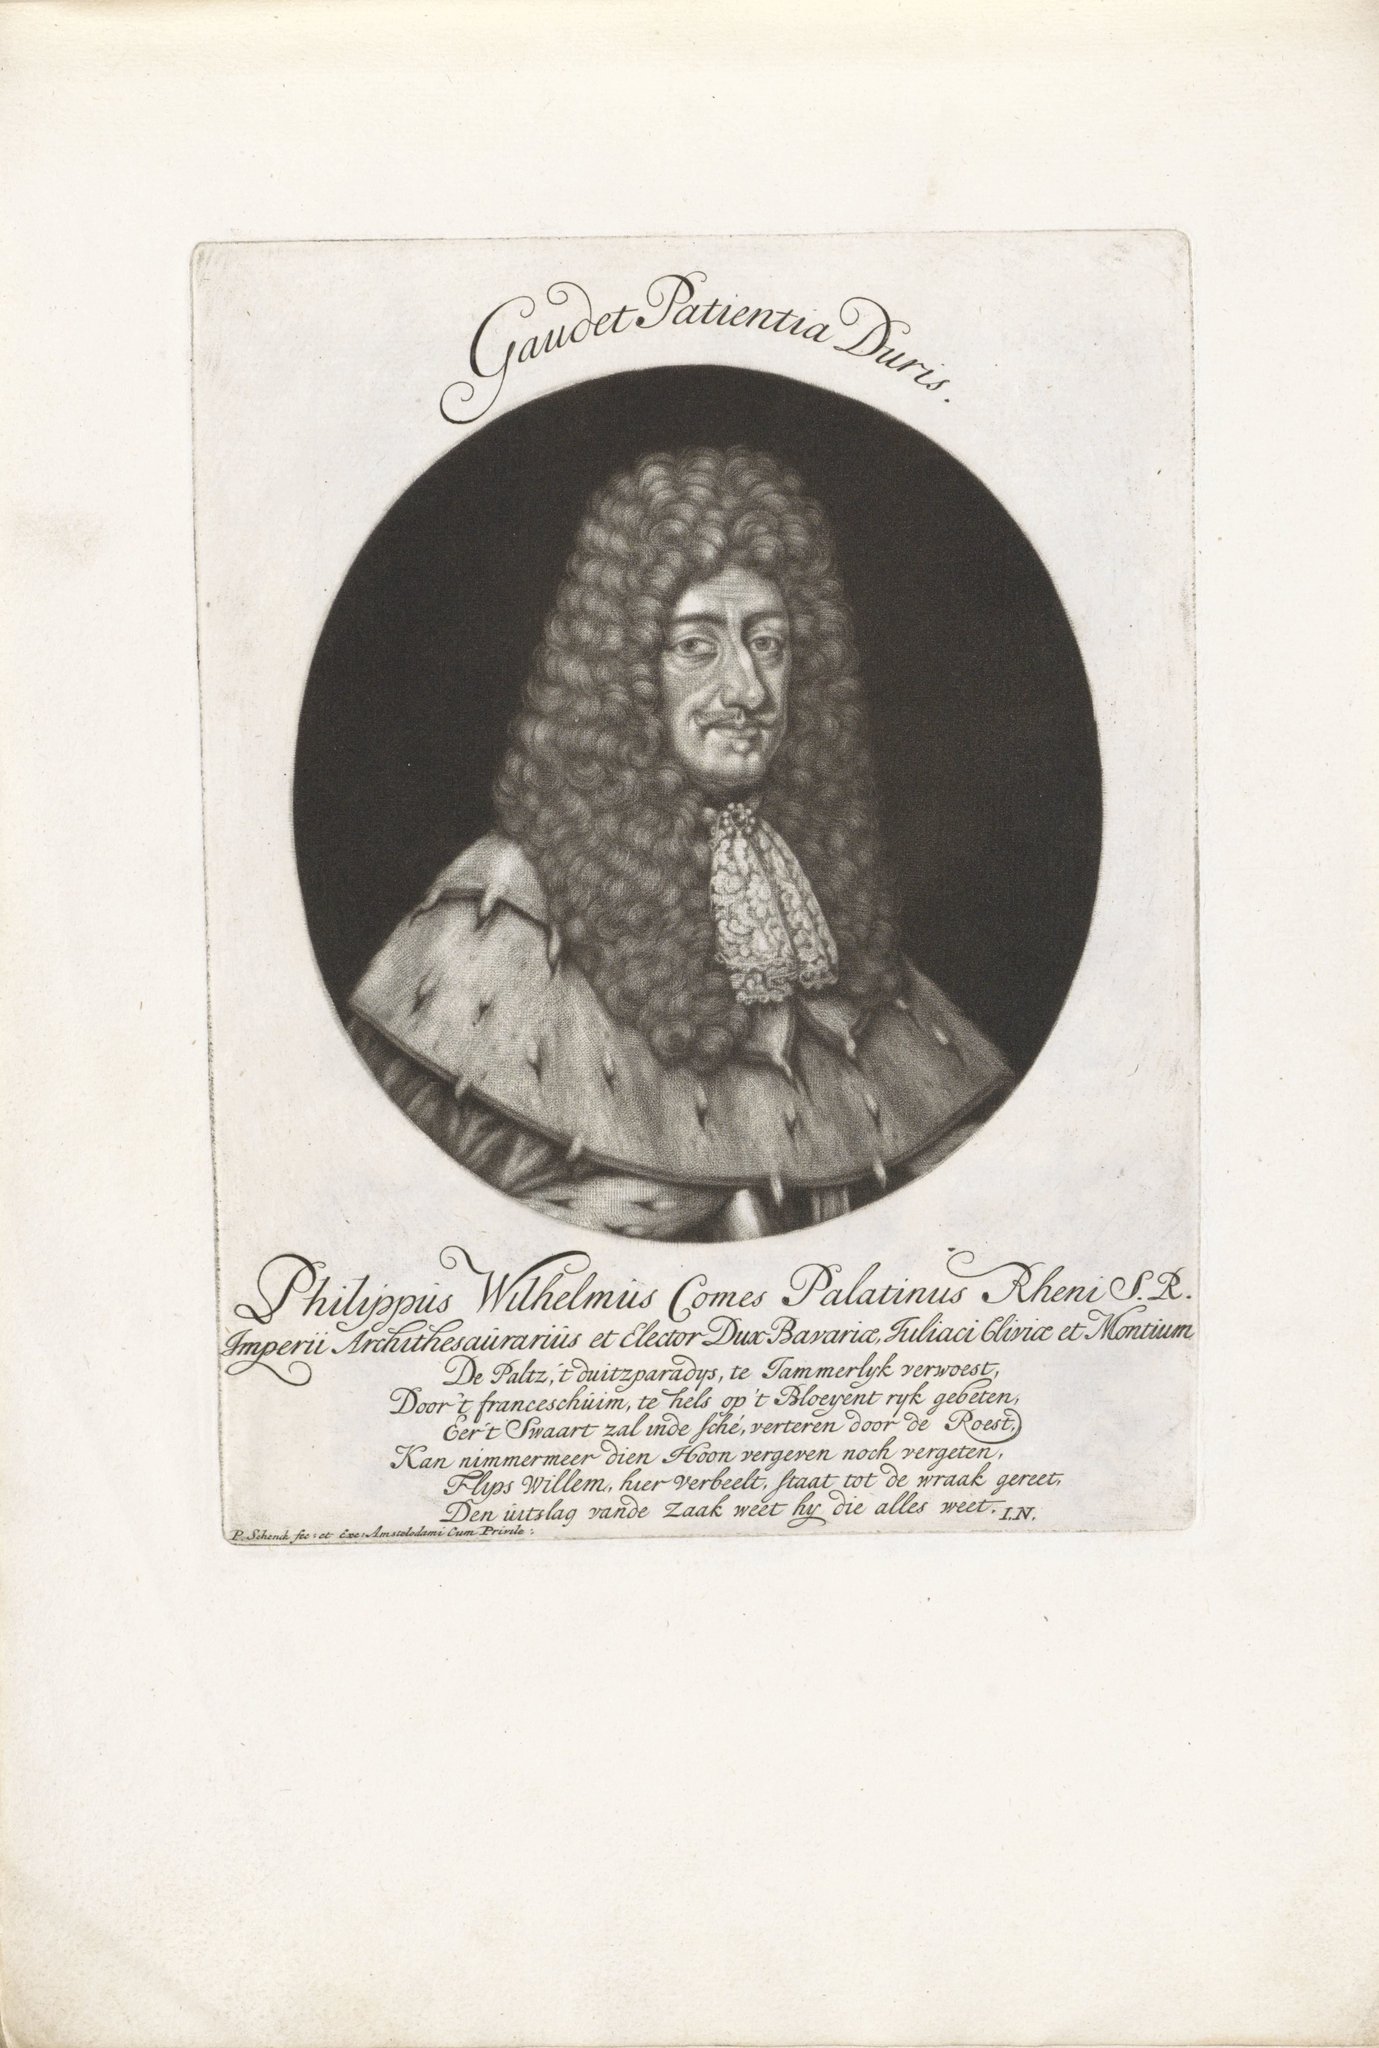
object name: print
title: Portret van Filips Willem, keurvorst van de Palts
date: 1690-1713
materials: paper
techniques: engraving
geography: amsterdam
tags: vienna, harness, wig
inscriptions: collector's mark: Lugt 2228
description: Filips Willem van de Palts, zoon van Wolfgang Willem van Palts-Neuburg. Hij draagt een pruik en een harnas.